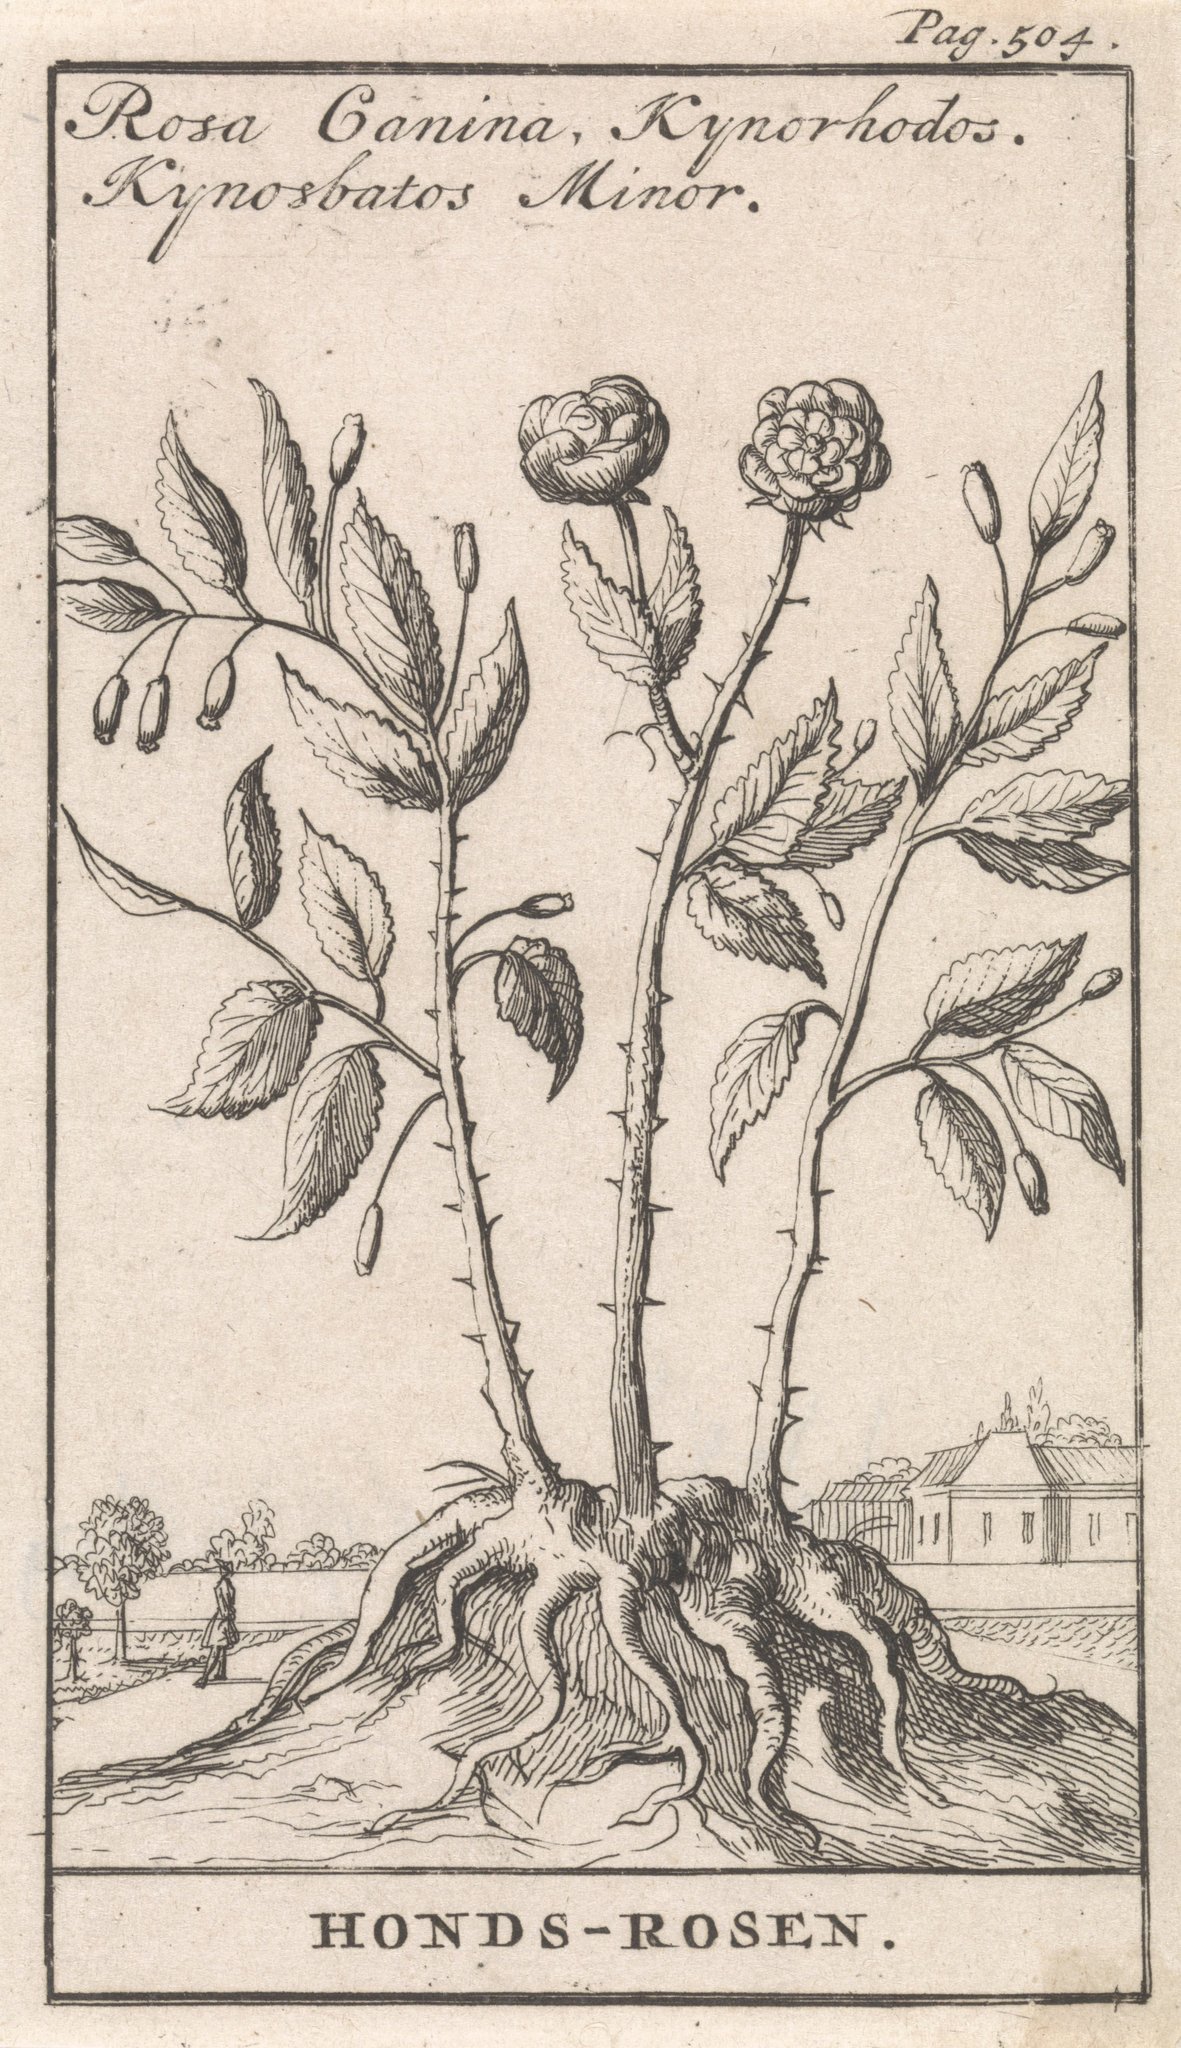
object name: print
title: Rosa Canina. Kynorhodos. Kynosbatos Minor / Honds-rosen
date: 1698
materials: paper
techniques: etching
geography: amsterdam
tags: plants and herbs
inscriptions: collector's mark: Lugt 2228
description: Illustratie uit: Blankaart, Steven. Den Neder-landschen herbarius ofte Kruid-boek der voornaamste kruiden. Amsterdam: Jan Claesz ten Hoorn, 1698.